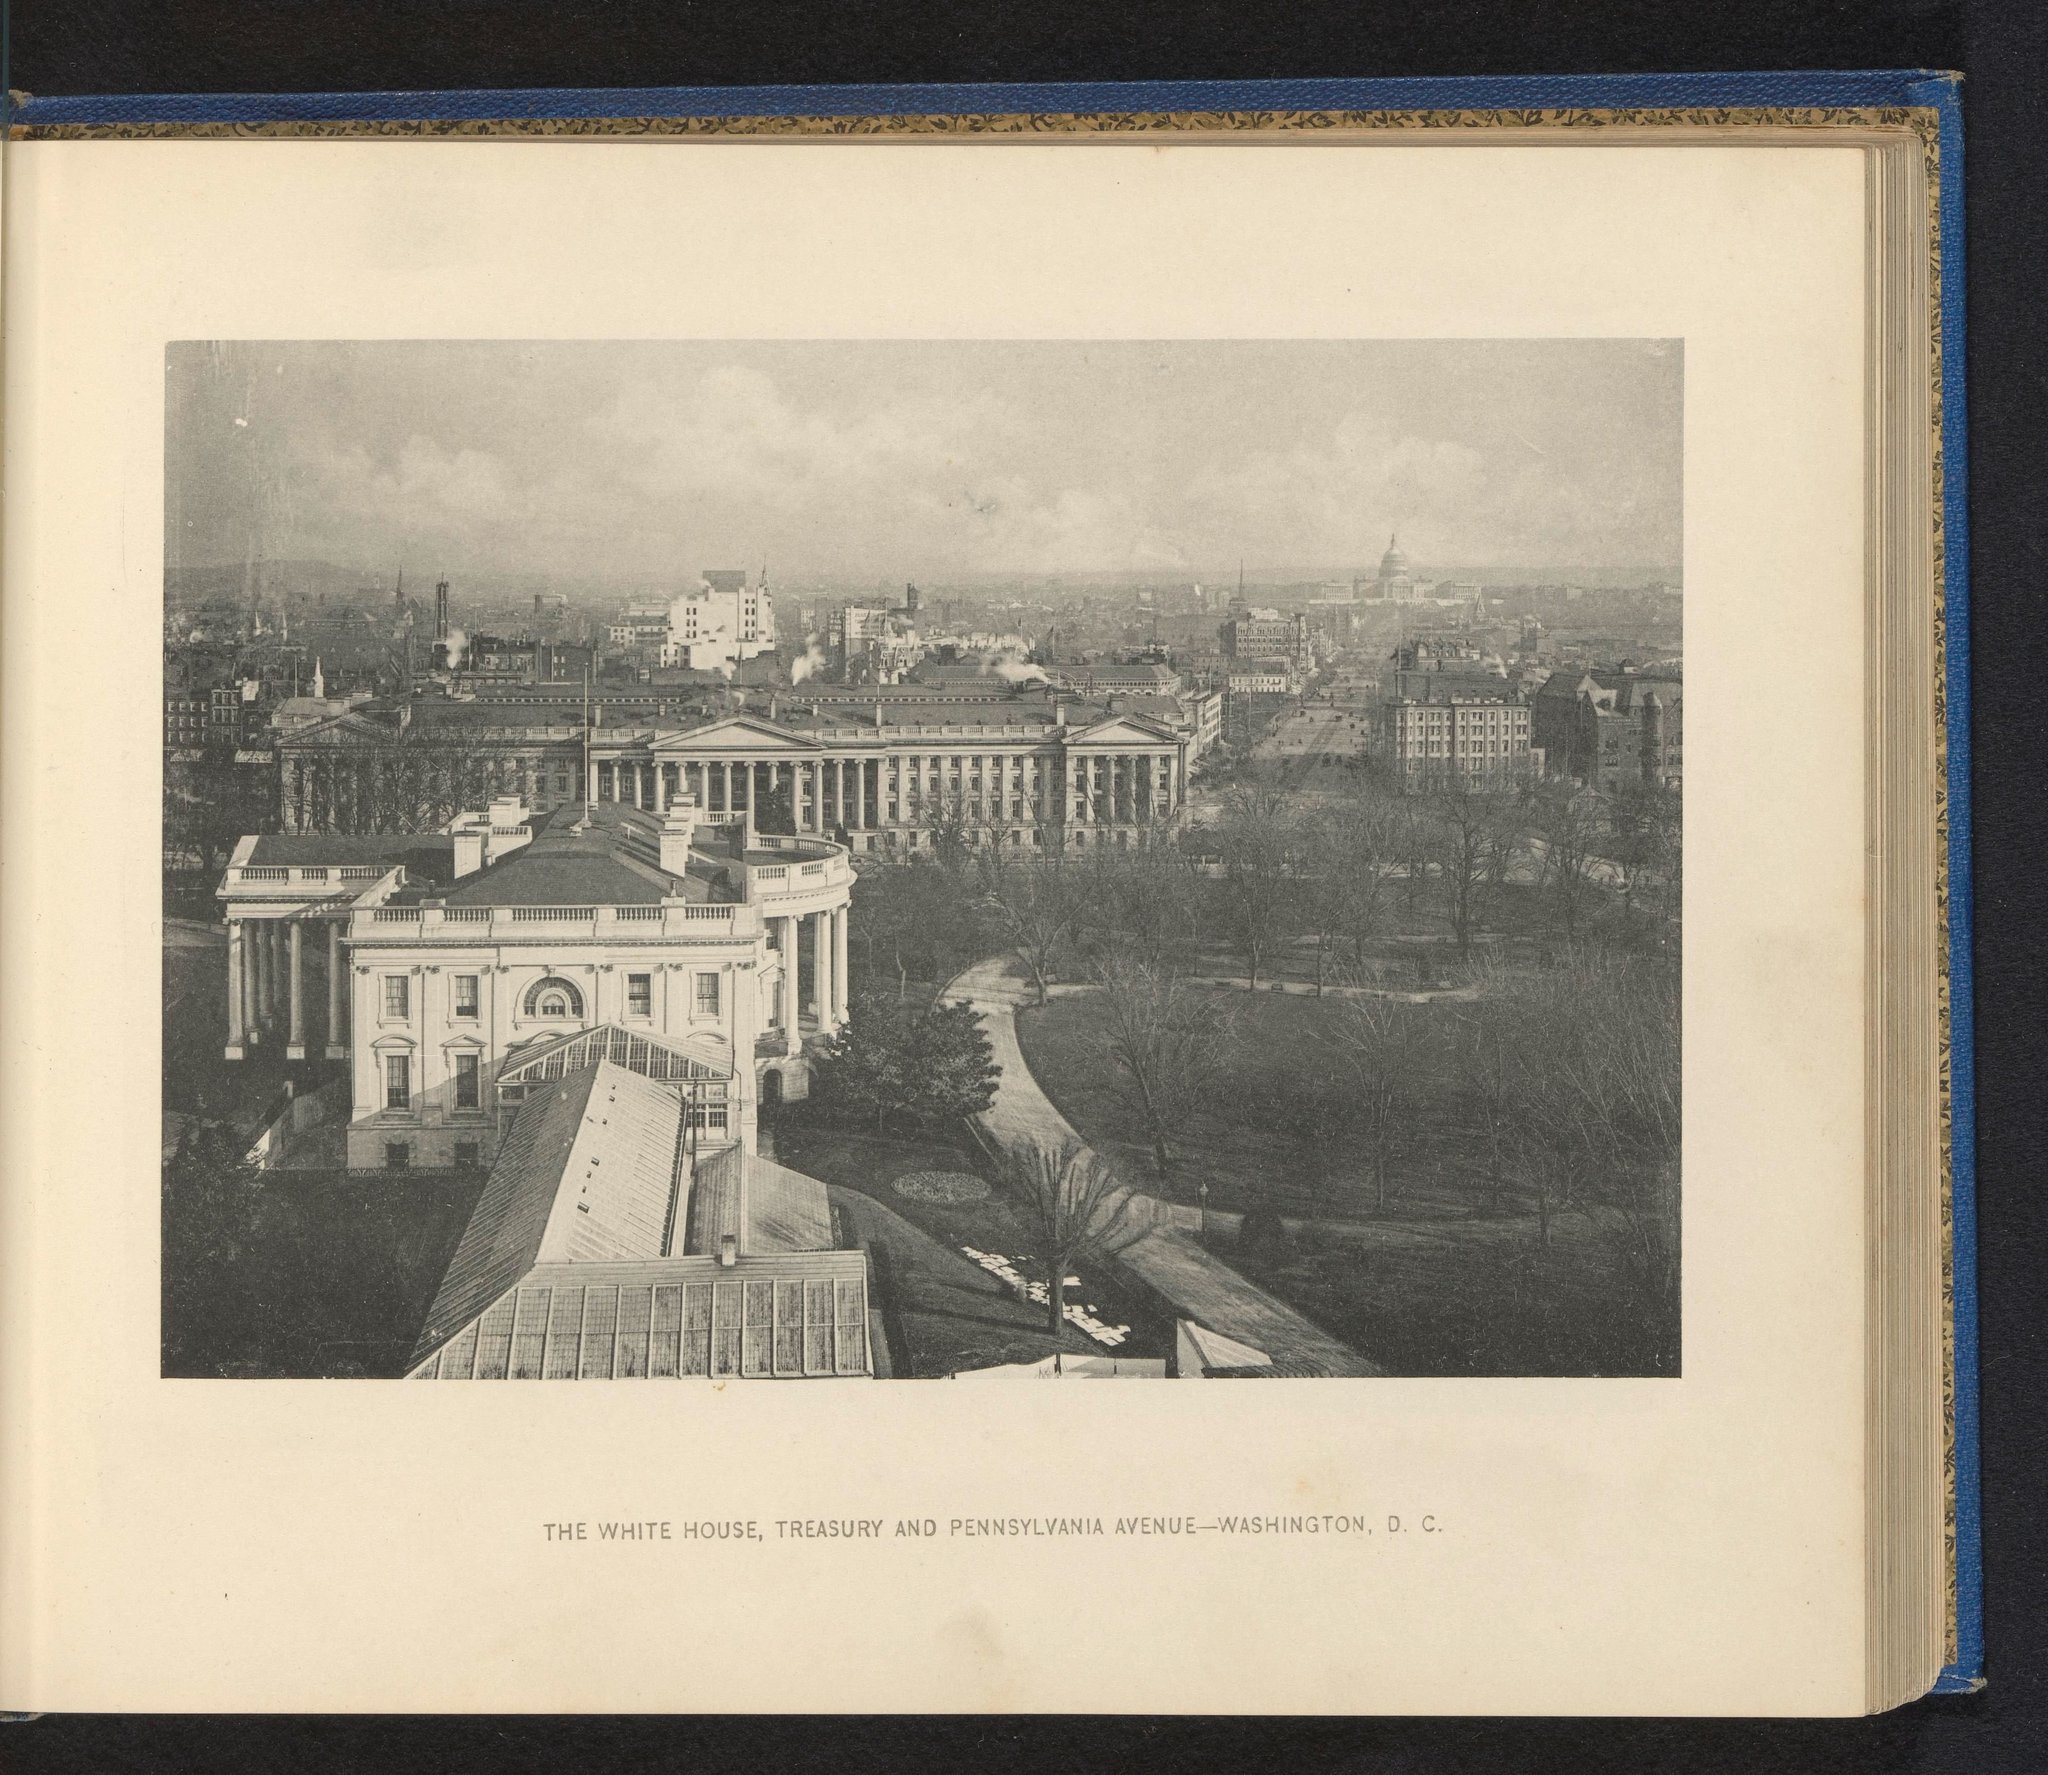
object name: photomechanical print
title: The White House, Treasury and Pennsylvania Avenue - Washington, D.C.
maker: Anonymous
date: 1883-1893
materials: paper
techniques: photograph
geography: washington d.c.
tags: national government